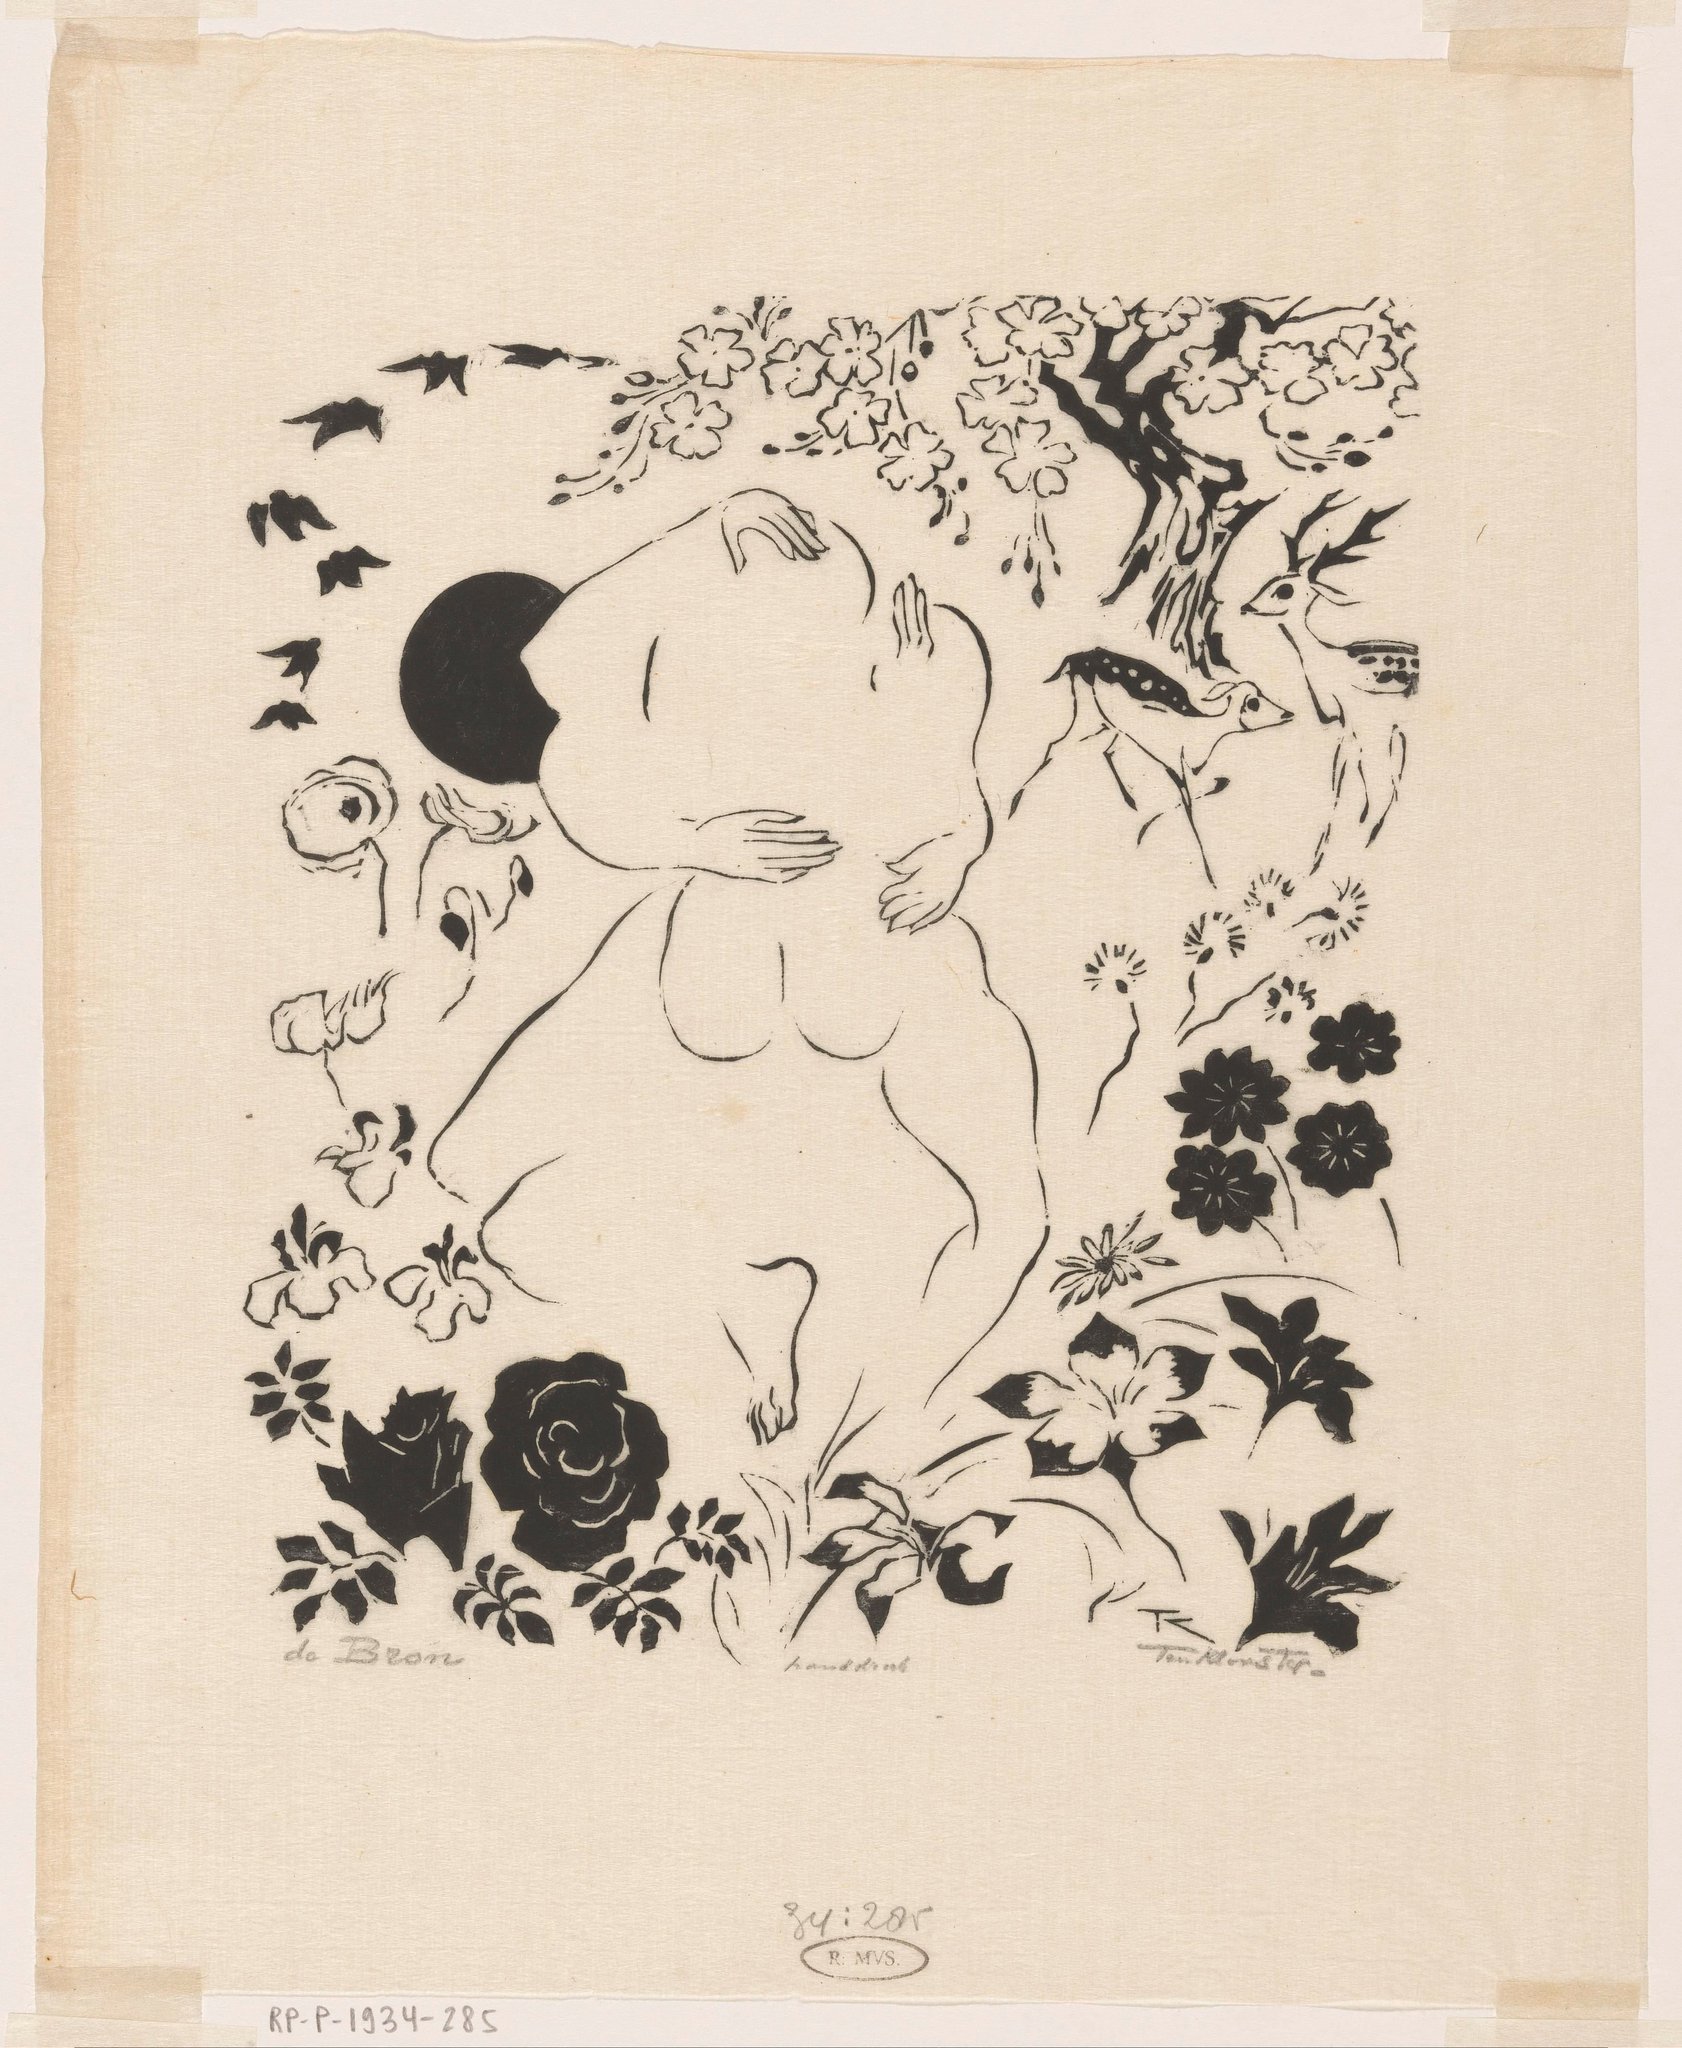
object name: print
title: De bron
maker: johannes frederik engelbert ten klooster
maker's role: draughtsman, print maker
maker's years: 1873-1940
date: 1883-1934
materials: paper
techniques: woodcut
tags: flowers, hoofed animals: deer, coitus, cohabiting, sexual intercourse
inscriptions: collector's mark: Lugt 2228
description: Twee of meer naakte figuren zijn in elkaar verstrengeld in een landschap met bloemen. Linksboven een zwerm vogels. Rechts op de achtergrond twee herten.